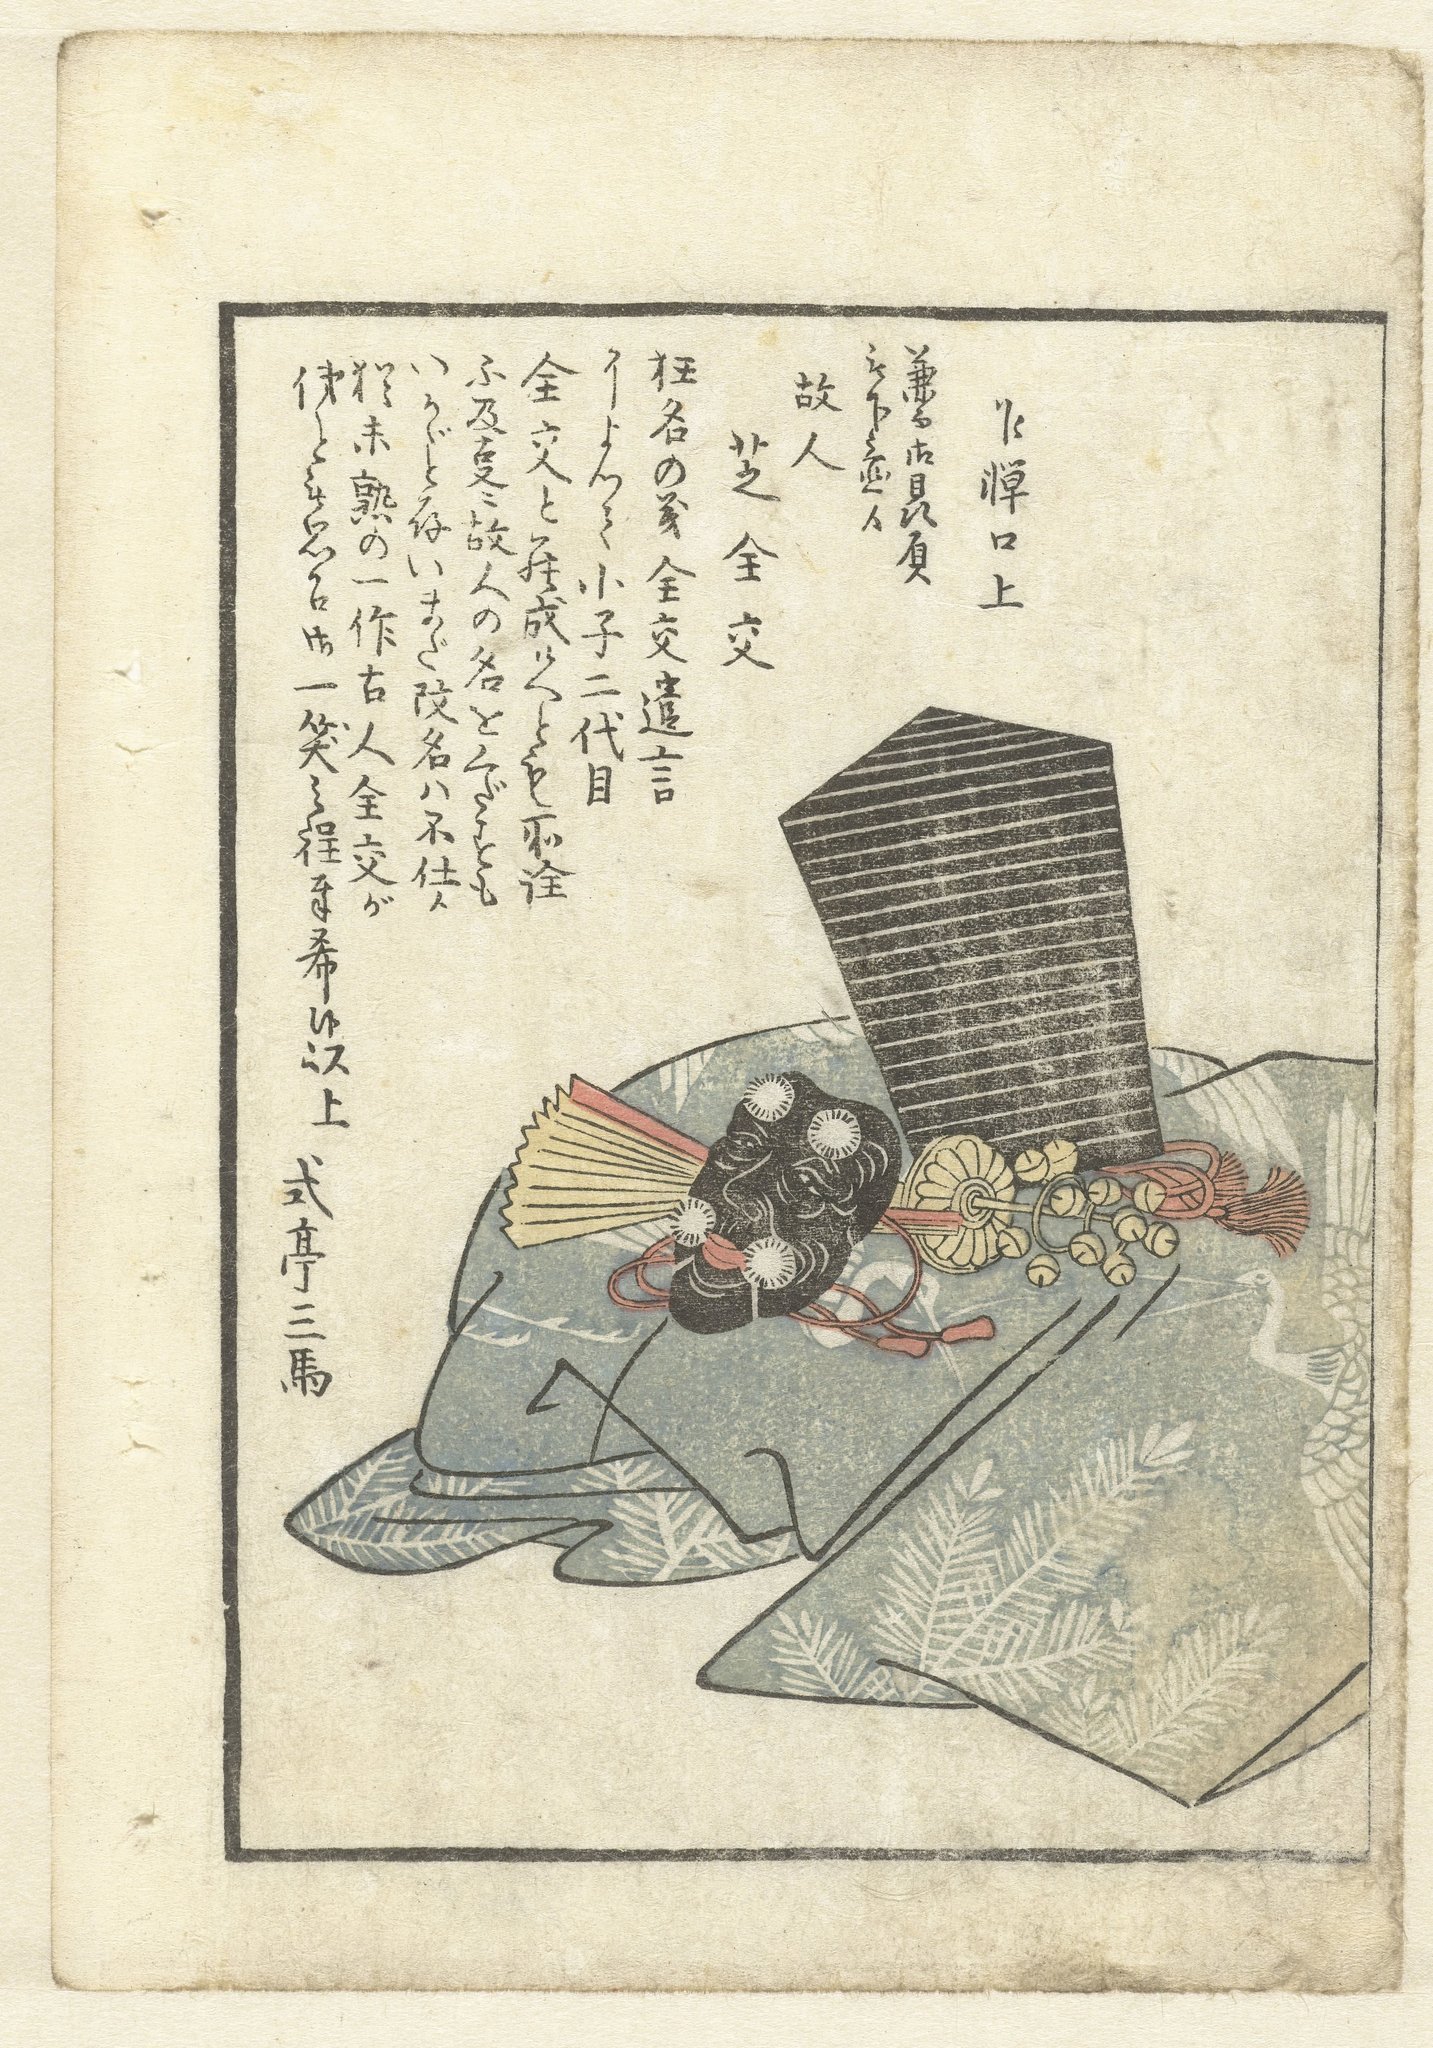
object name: print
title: Yakusha gakuya tsu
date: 1799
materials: paper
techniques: woodcut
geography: edo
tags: mask, fashion, clothing, fan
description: Zwart masker, hoofddeksel en waaier op een mantel met het patroon van kraanvogels en dennentakken; de attributen van een Noh acteur in een Sanbaso rol. Blad, met linksboven een deel van de inleiding, uit het Japanse boek Yakusha gakuya tsu.